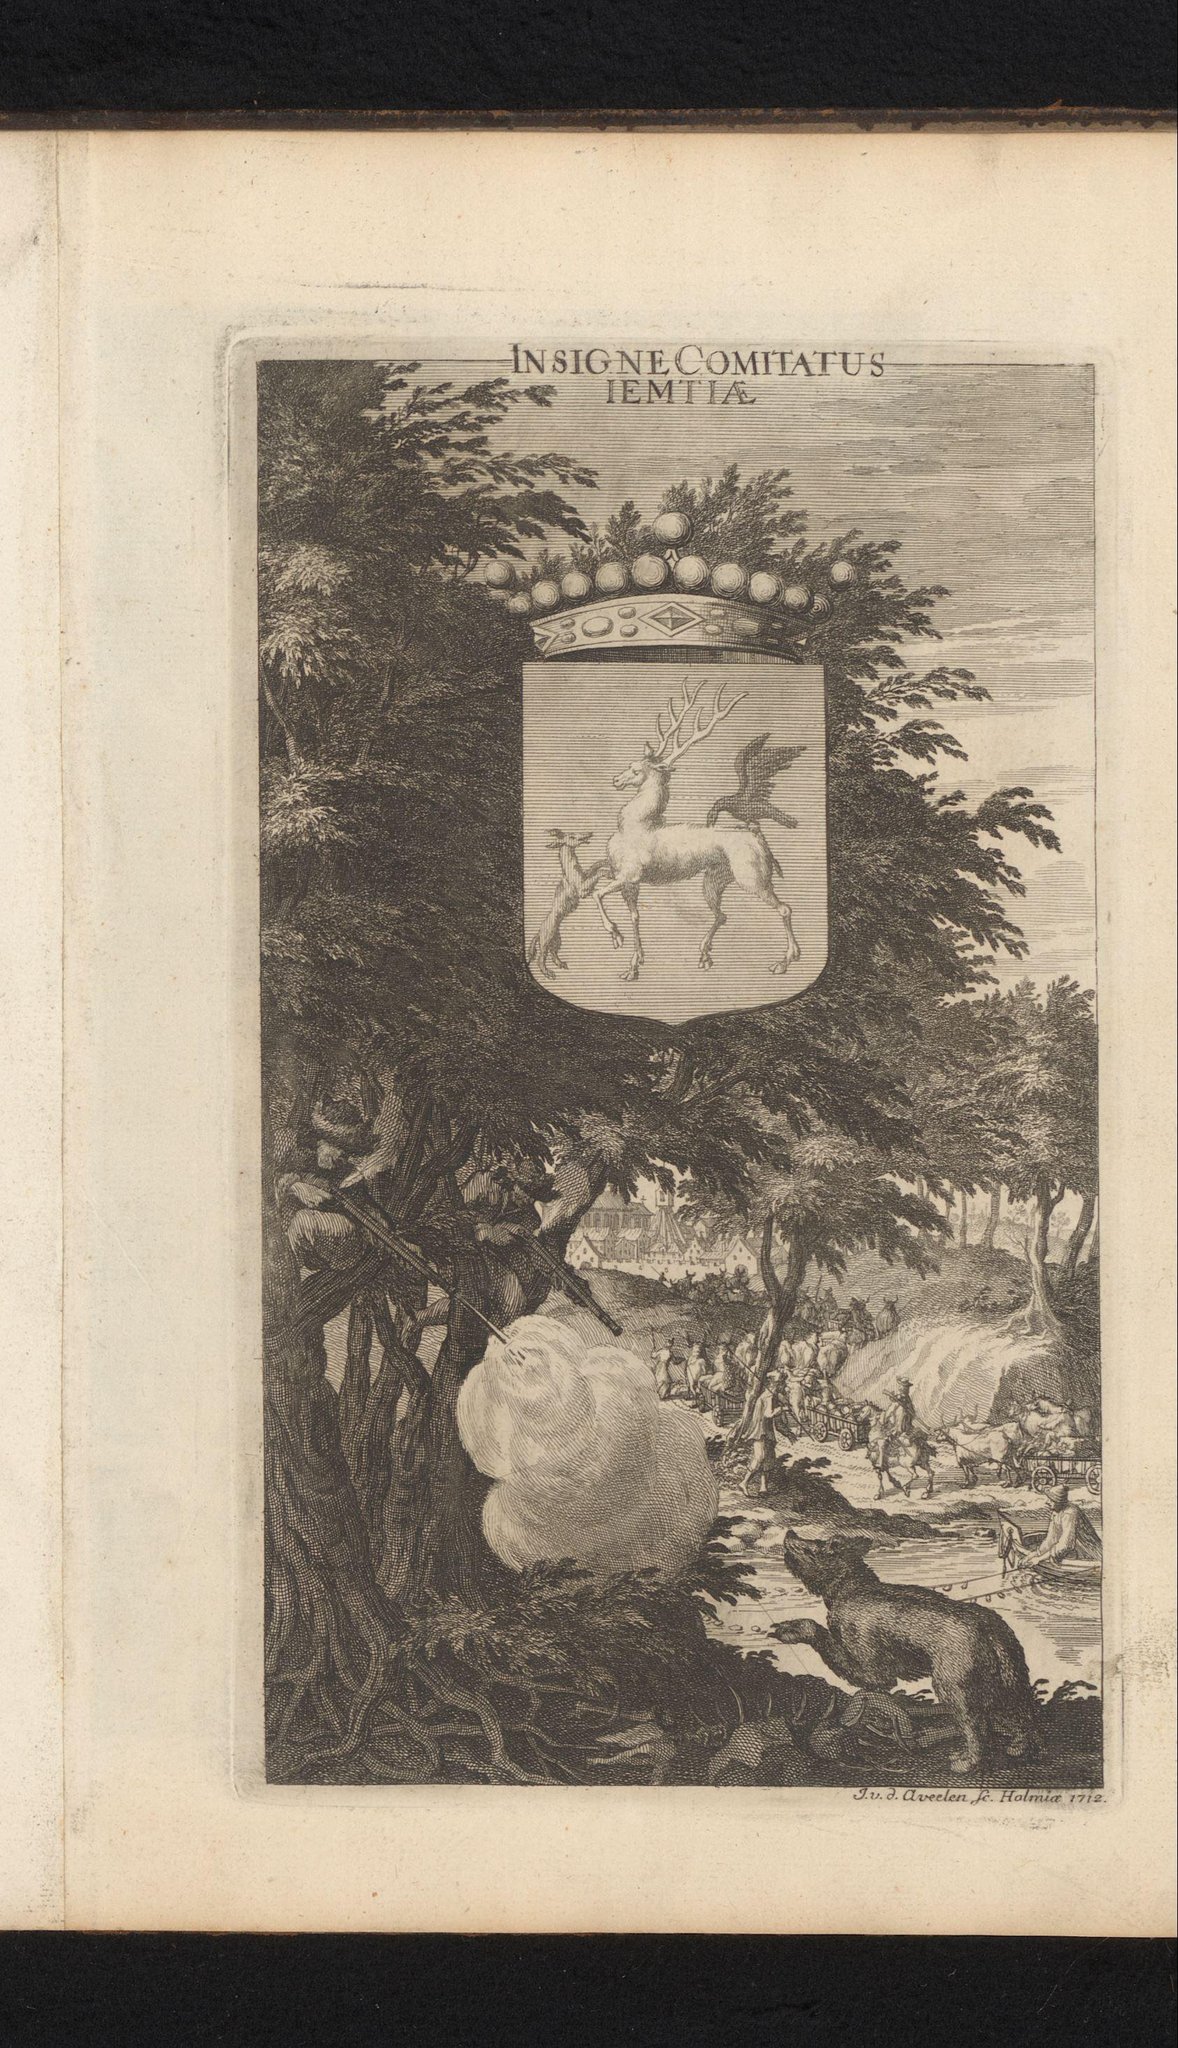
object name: print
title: Jachttafereel met het wapen van Jämtland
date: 1712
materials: paper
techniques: etching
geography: stockholm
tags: coat of arms (as symbol of the state, etc.)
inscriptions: date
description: Kungliga Biblioteket, 'Suecia': http://www.kb.se/samlingarna/Kartor-bilder/Suecia-antiqua/ (geraadpleegd november 2016).